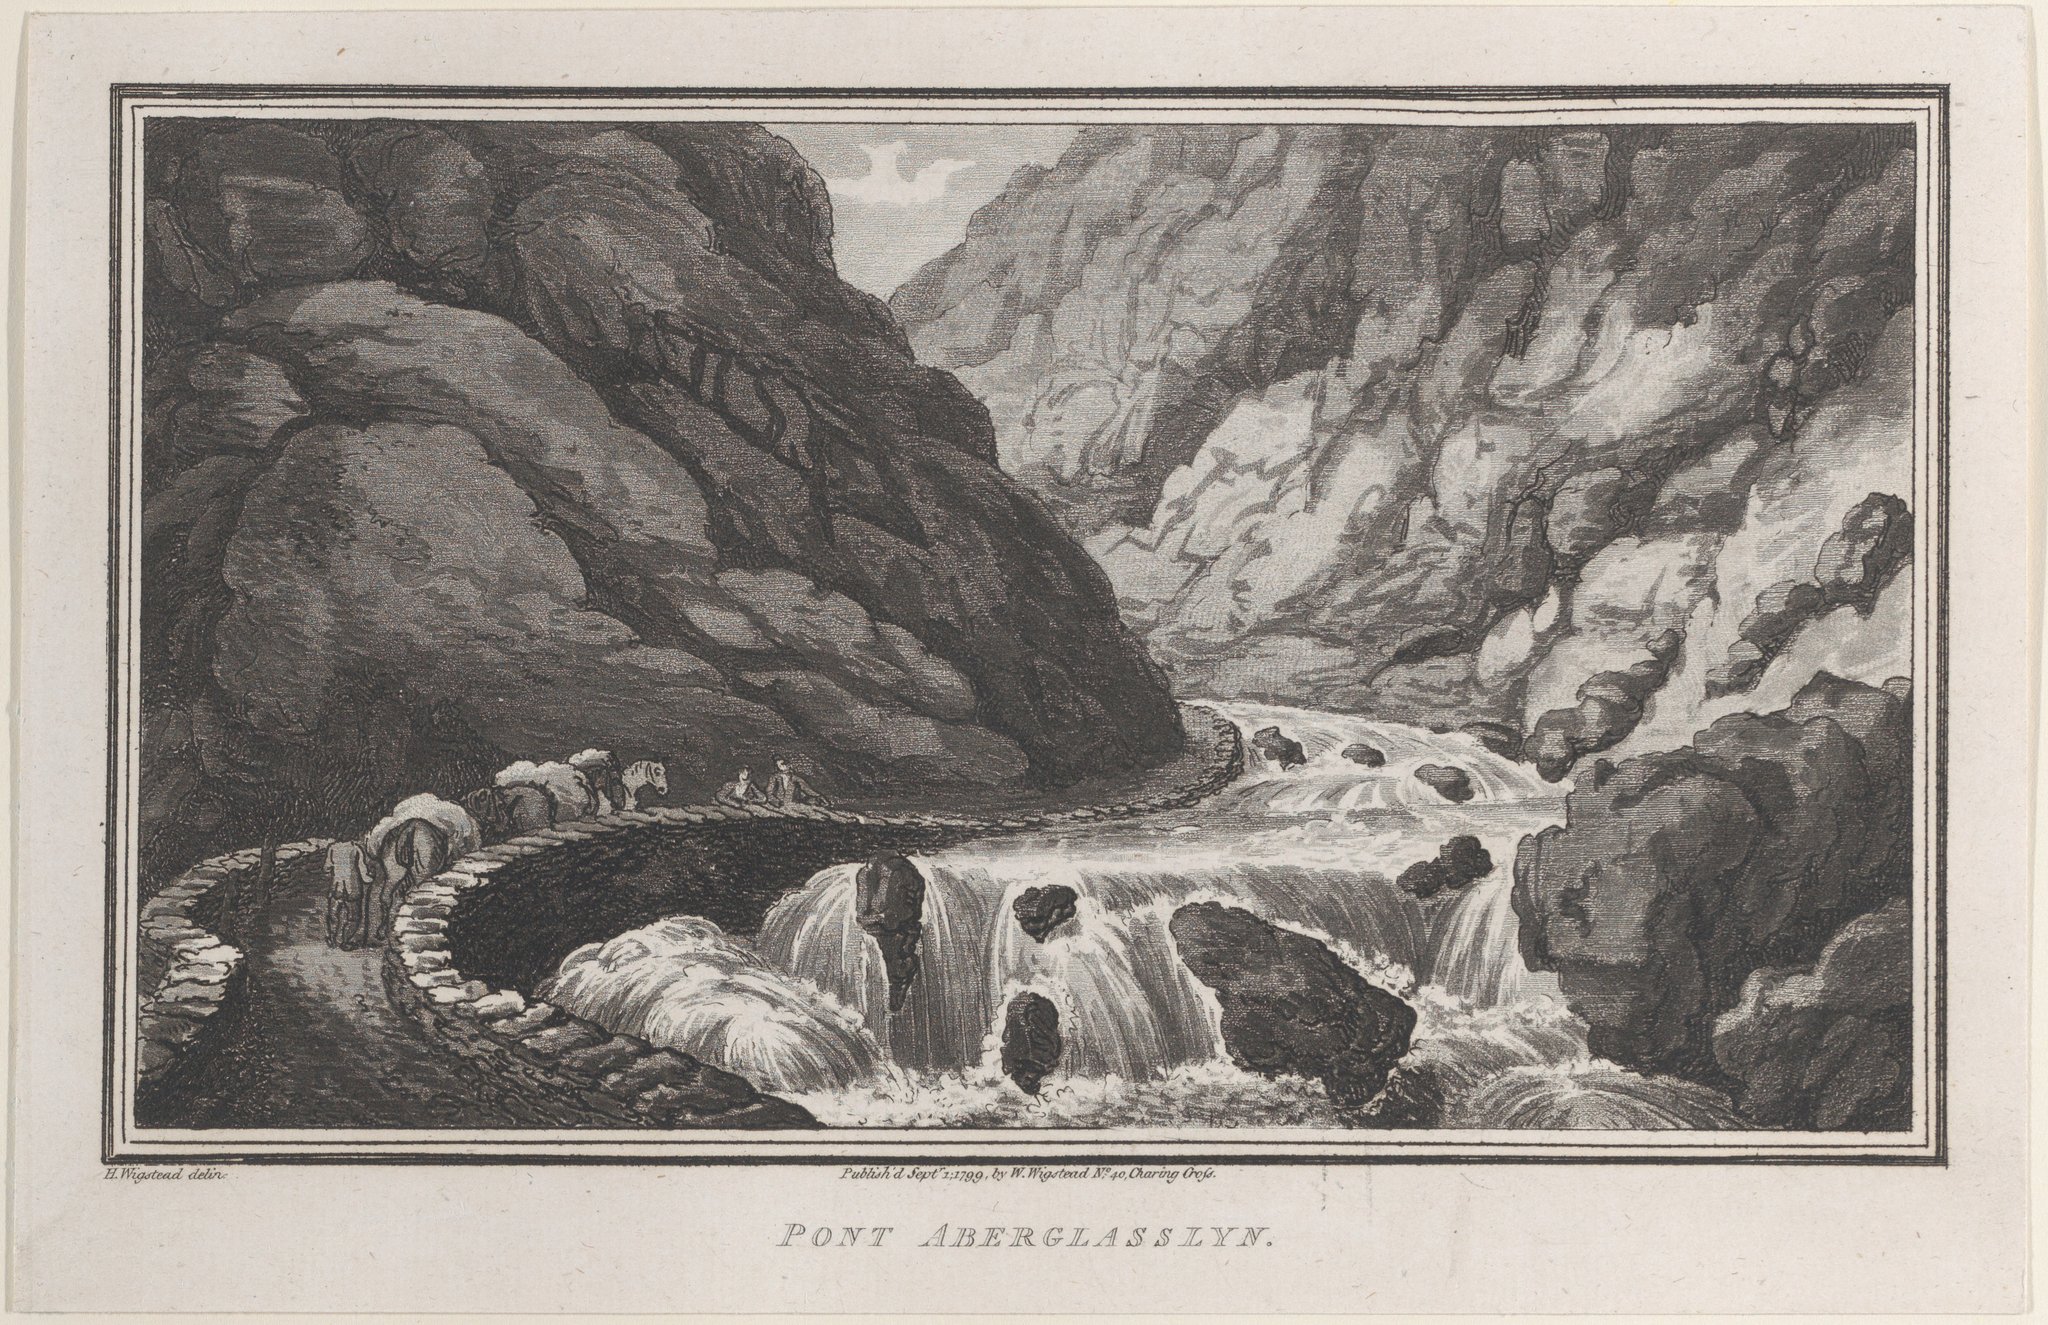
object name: print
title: Pont Aberglasslyn, from "Remarks on a Tour to North and South Wales, in the year 1797"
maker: john hill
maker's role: artist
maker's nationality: british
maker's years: 1714-1775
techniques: aquatint, etching